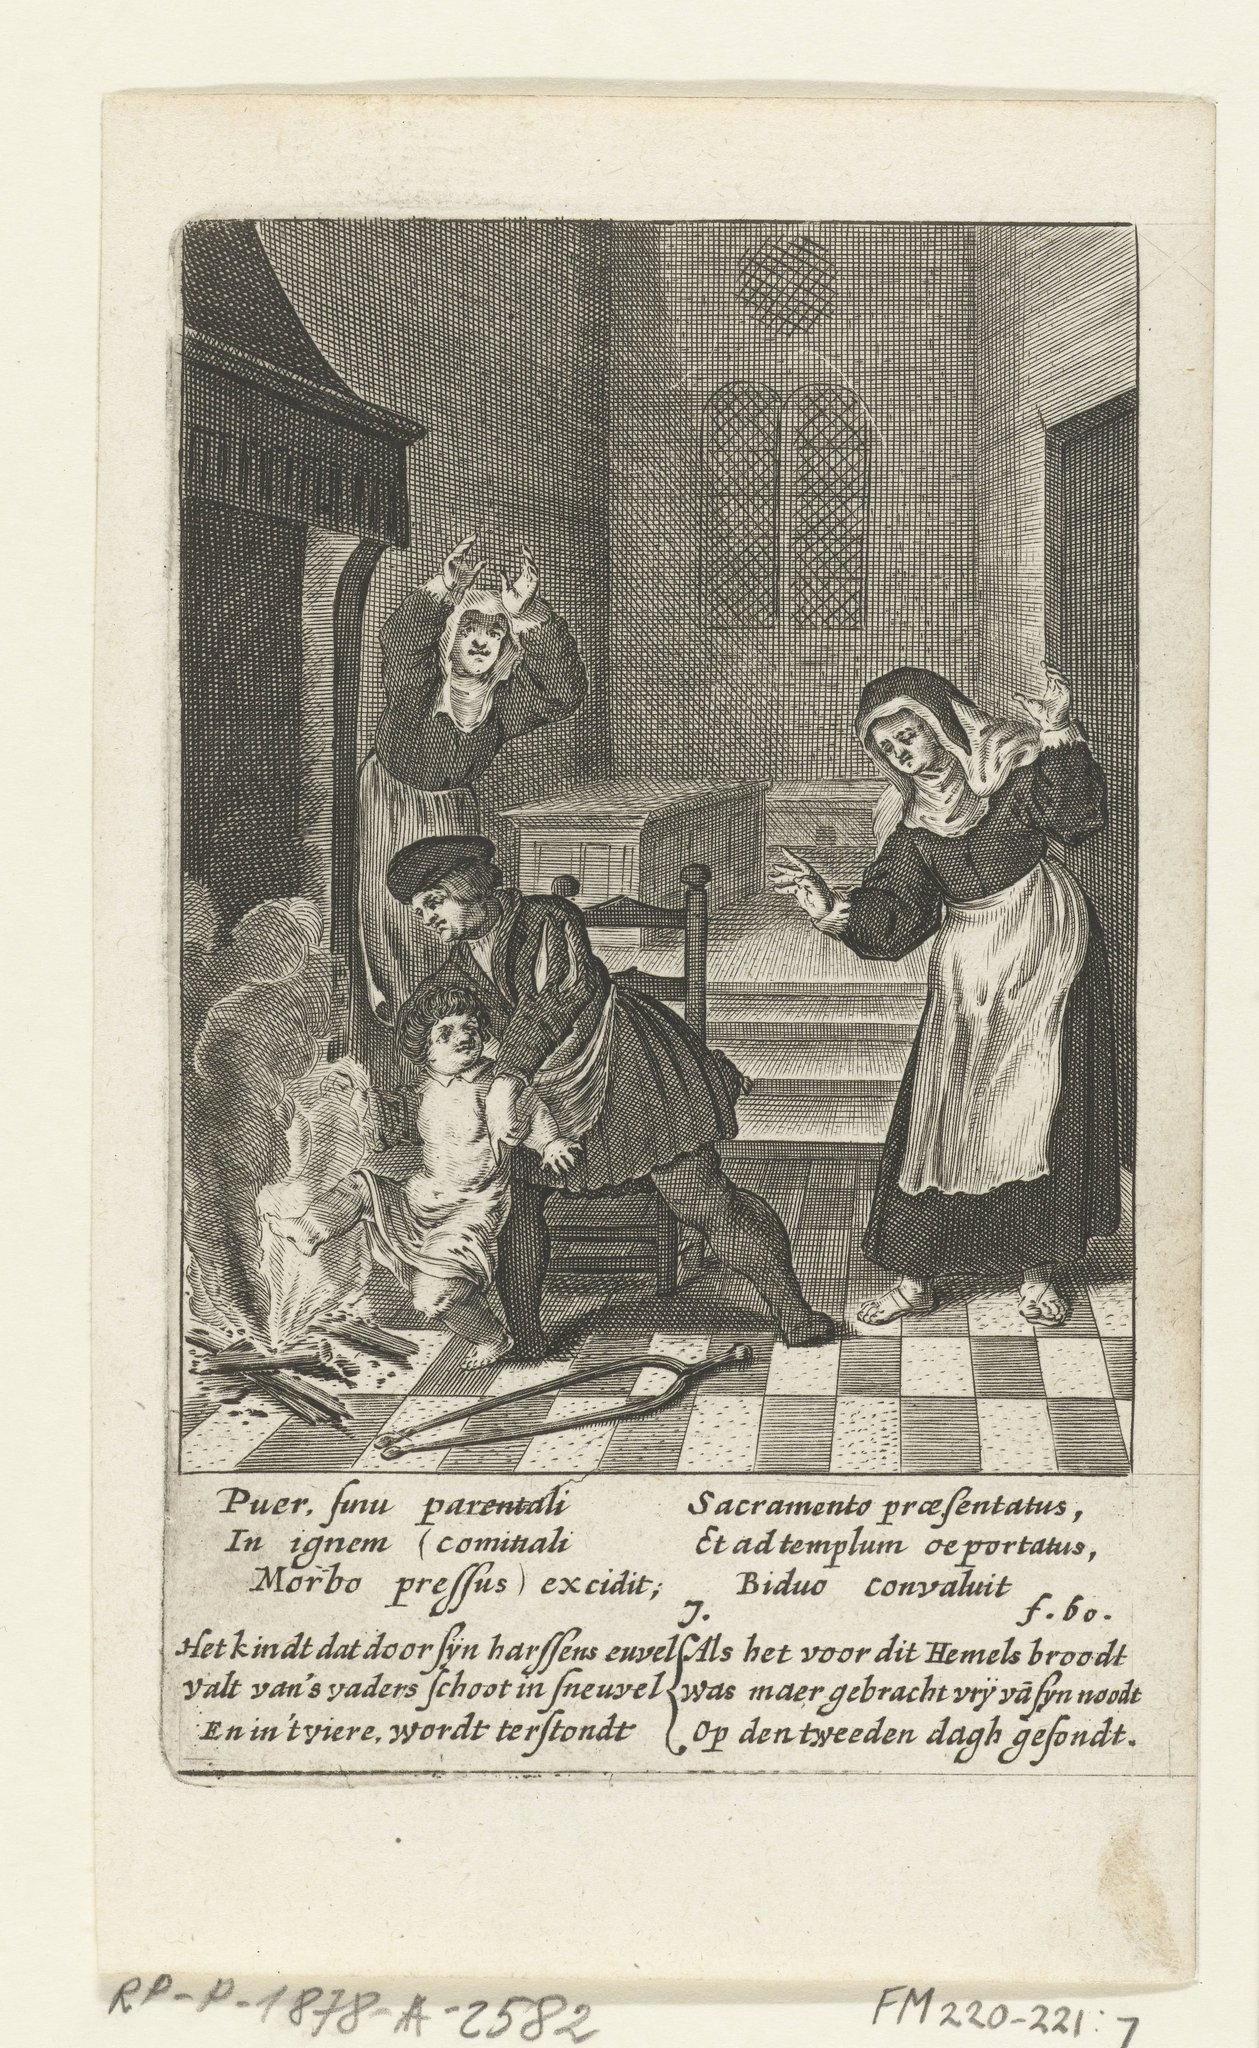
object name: print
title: Een kind valt in het vuur, 7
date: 1639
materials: paper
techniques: engraving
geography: southern netherlands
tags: amsterdam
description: Een kind valt in het vuur en wordt genezen als hij bij de hostie wordt gebracht. De vader trekt het kind uit het vuur. Prent nr. 7 uit de serie van 16 voorstellingen van Het Mirakel van Amsterdam, naar de gebeurtenissen op 15 maart 1345. Onder de voorstelling twee zesregelige verzen in het Latijn en Nederlands.